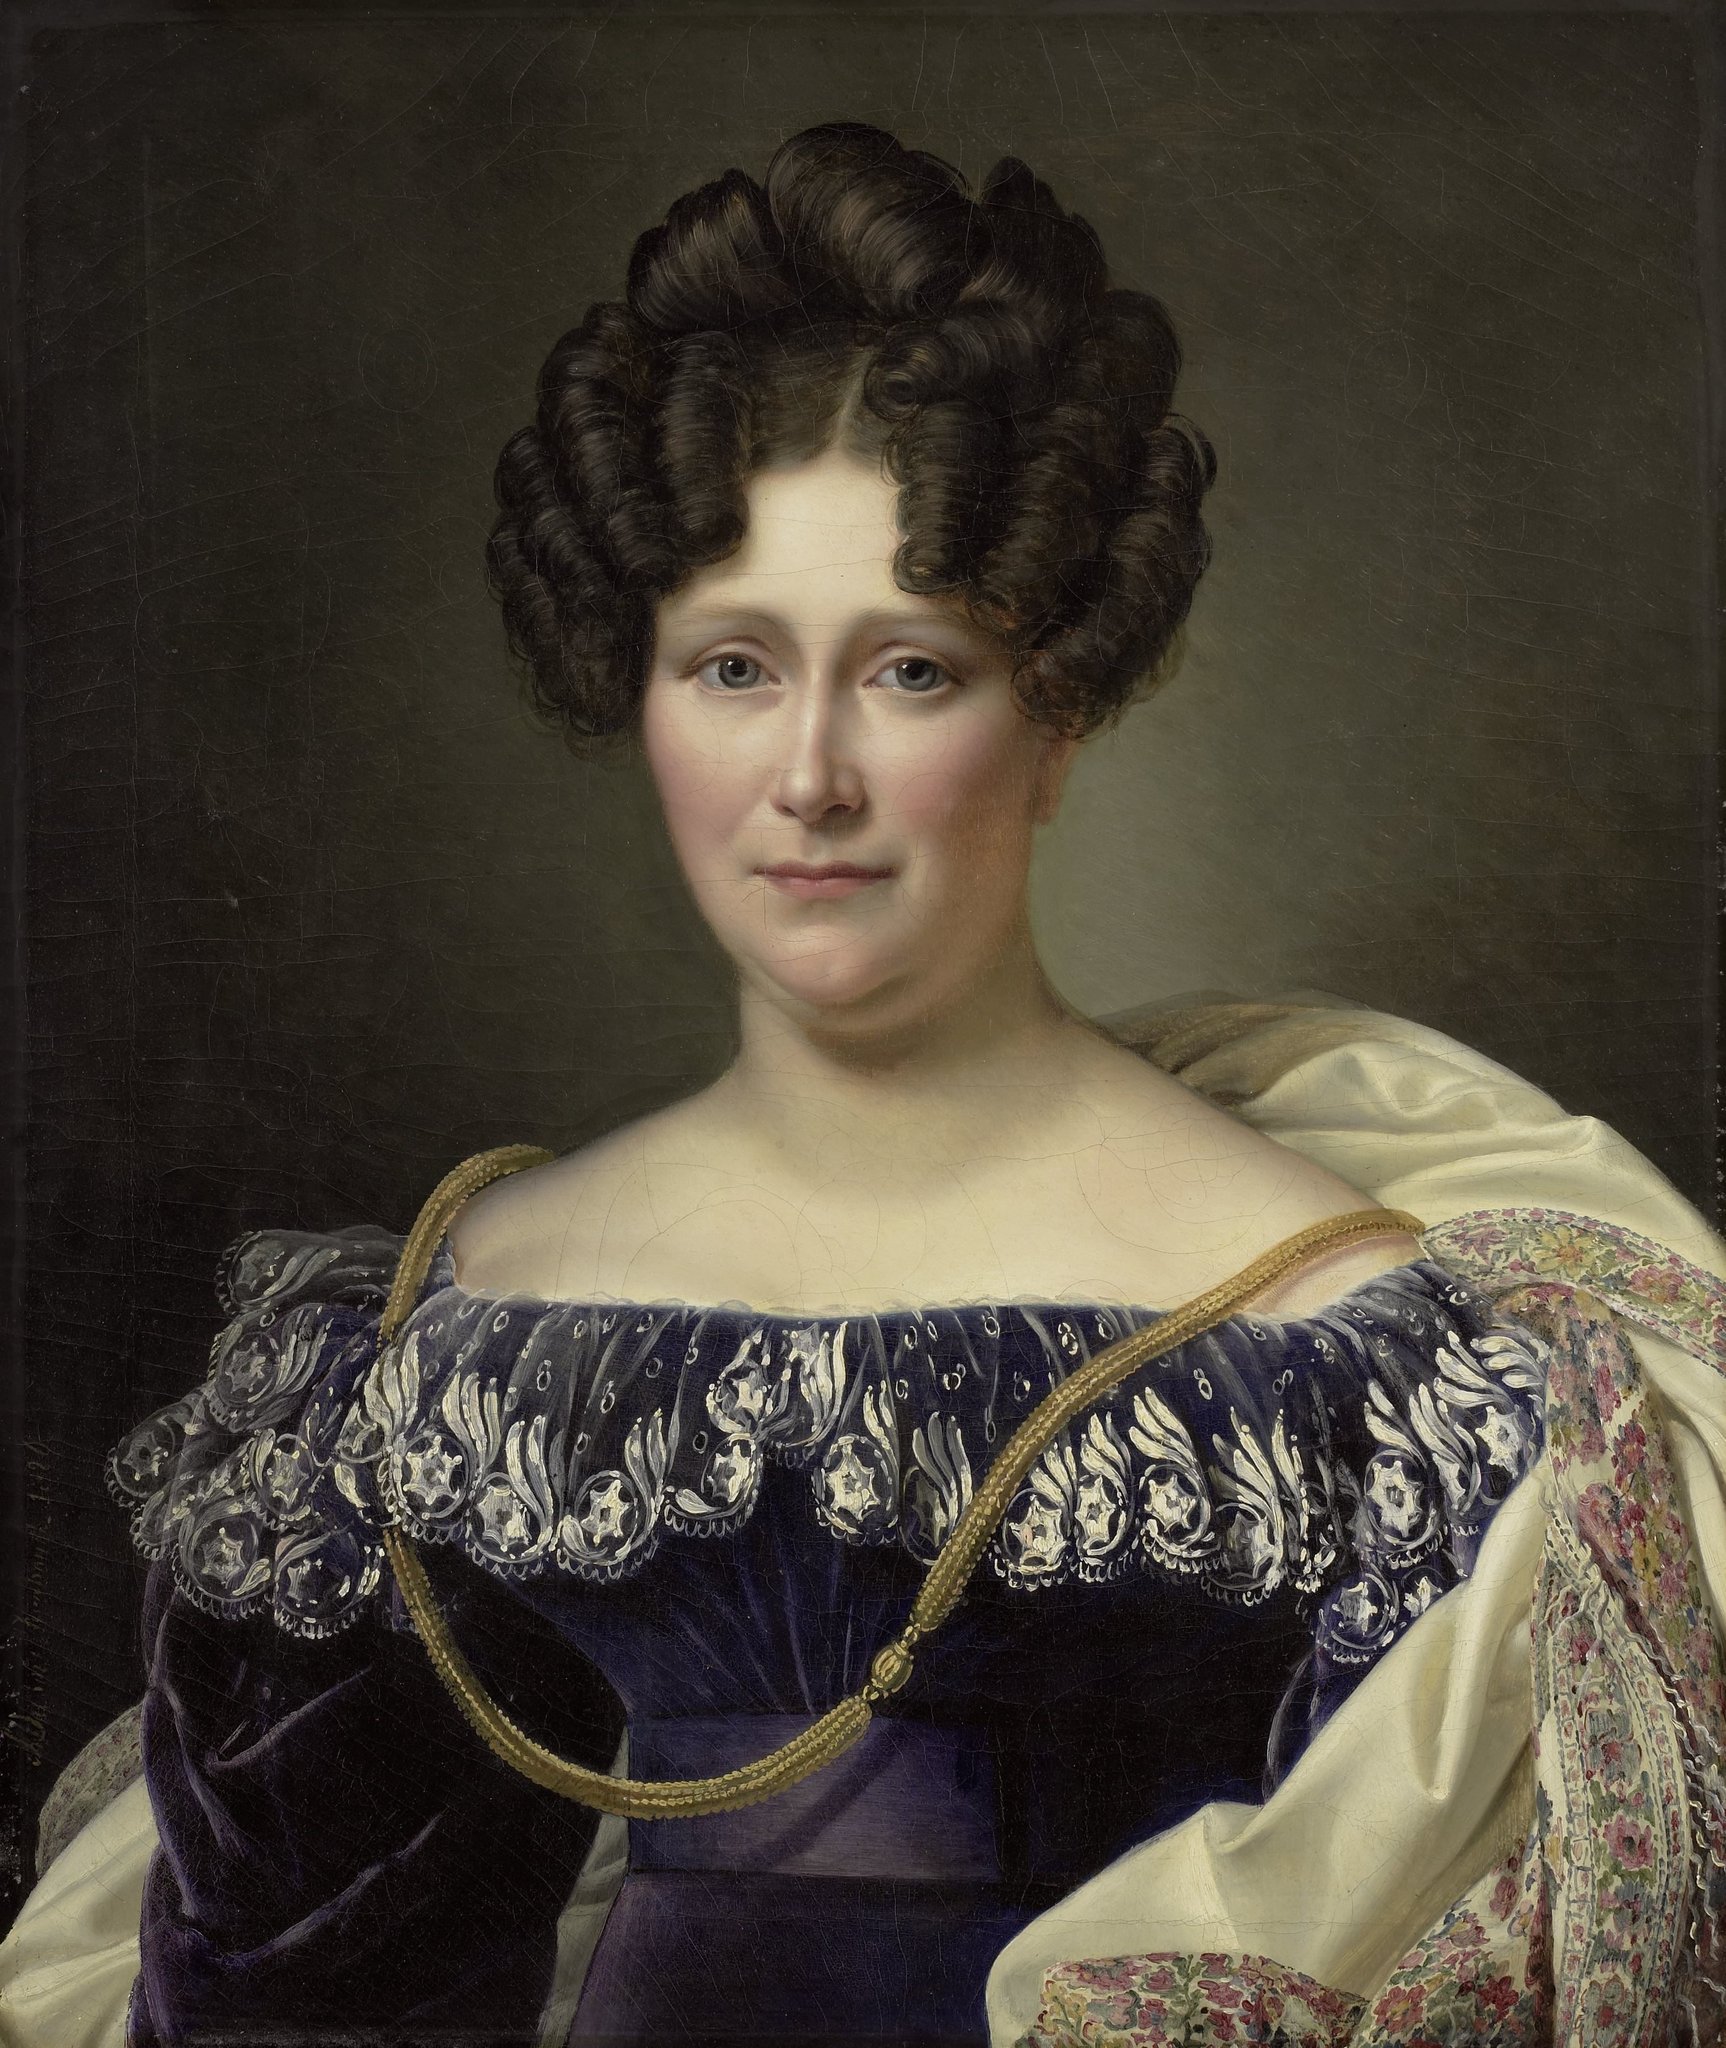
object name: painting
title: Johanna Henriette Engelen (1789-1878), second Wife of Daniel Francis Schas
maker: alexandre jean dubois drahonet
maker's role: painter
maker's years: 1791-1834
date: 1826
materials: canvas, oil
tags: daniel francis schas, johanna henriette engelen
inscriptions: signature and date: ‘AJ Dubois Drahonet 1826’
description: Portret van Johanna Henriette Engelen, sedert 1814 de tweede echtgenote van Daniel Francis Schas. Ten halven lijve, zittend, in een paarse fluwelen japon, om de hals een ketting. Pendant van SK-A-4153.